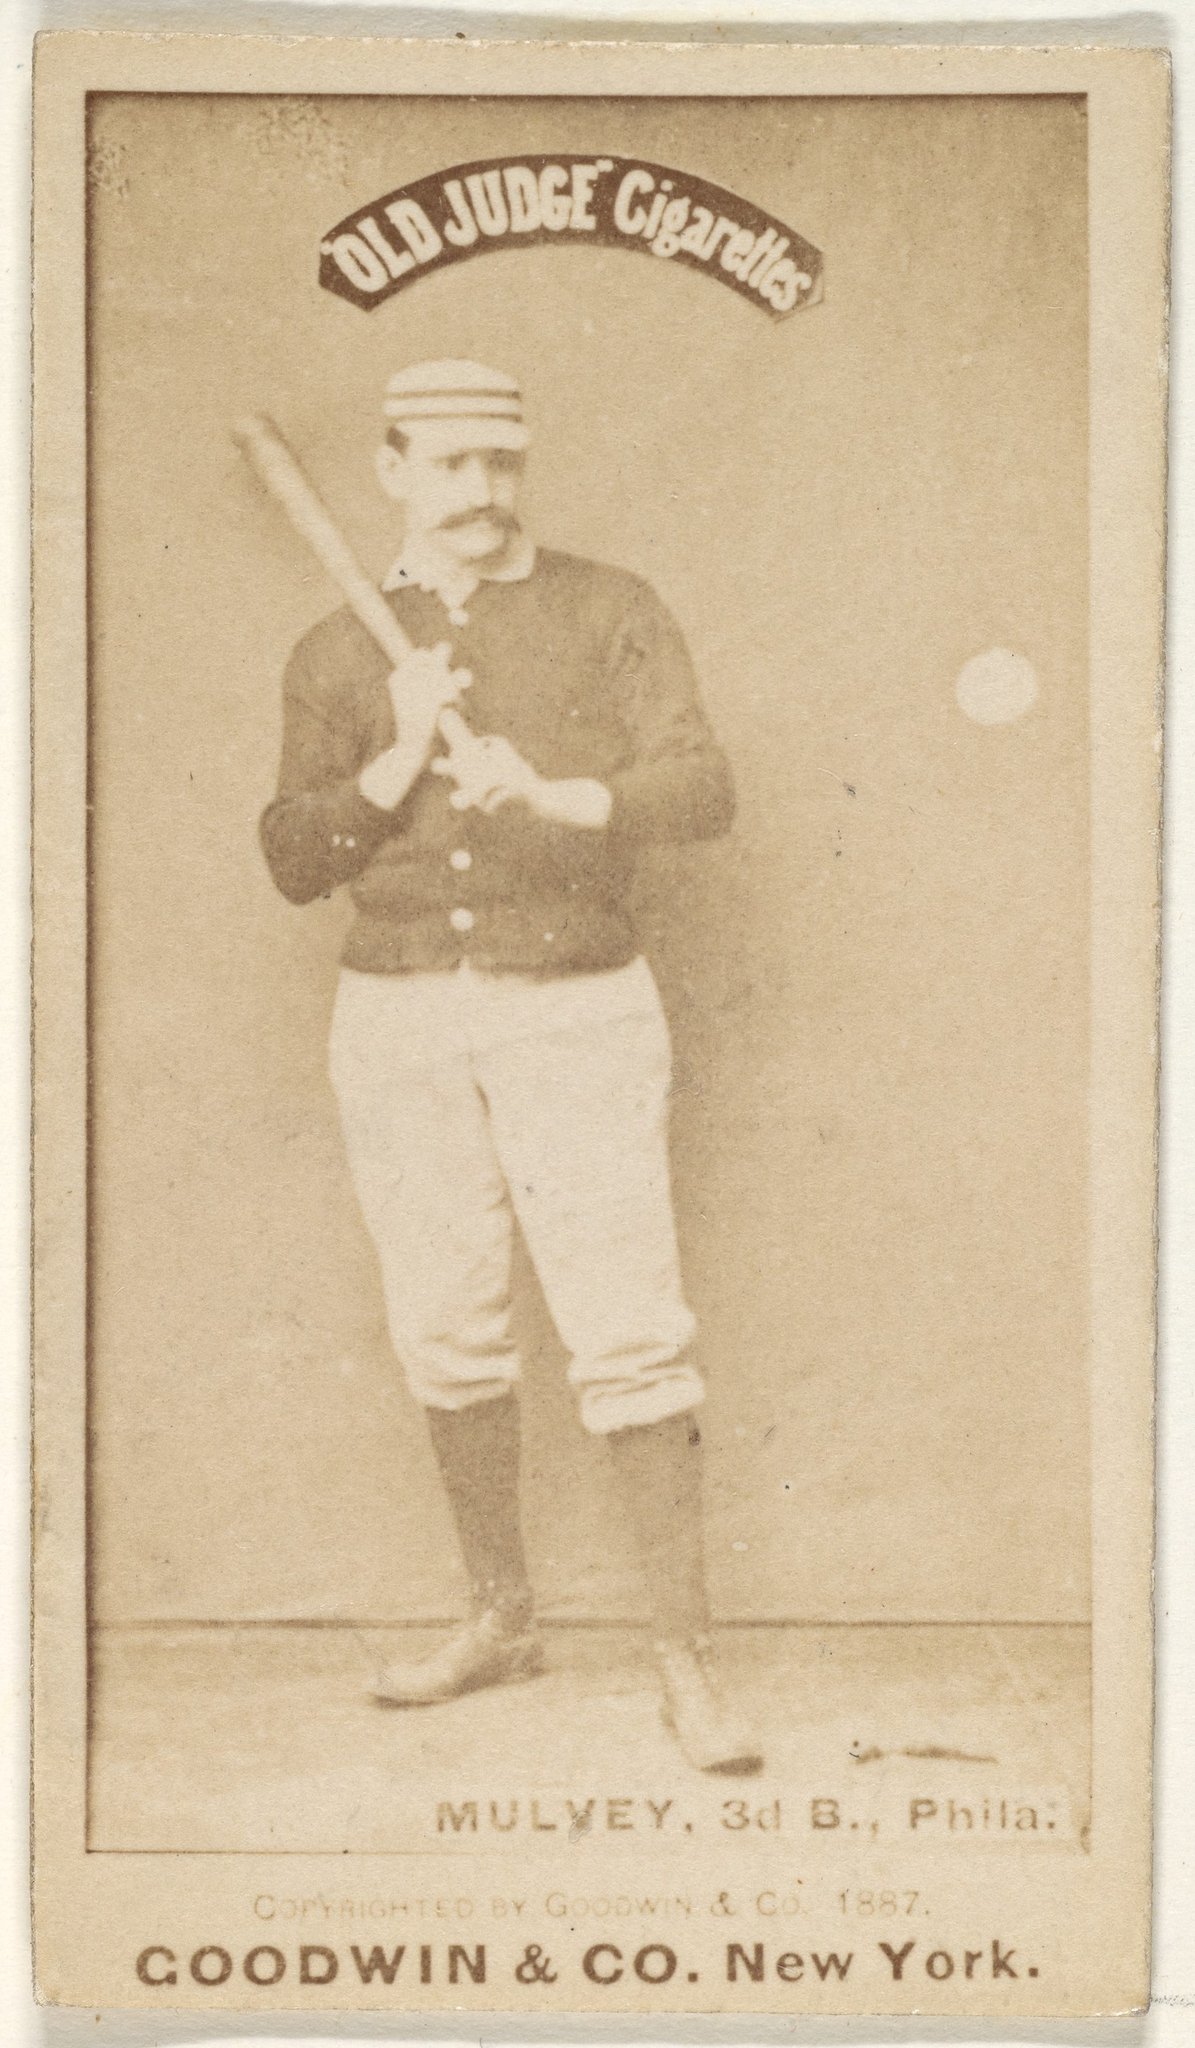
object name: baseball card, photograph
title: Joseph H. "Joe" Mulvey, 3rd Base, Philadelphia, from the Old Judge series (N172) for Old Judge Cigarettes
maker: goodwin & company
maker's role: publisher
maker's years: 1850-1950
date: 1887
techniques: albumen silver print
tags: men,portraits,baseball,athletes